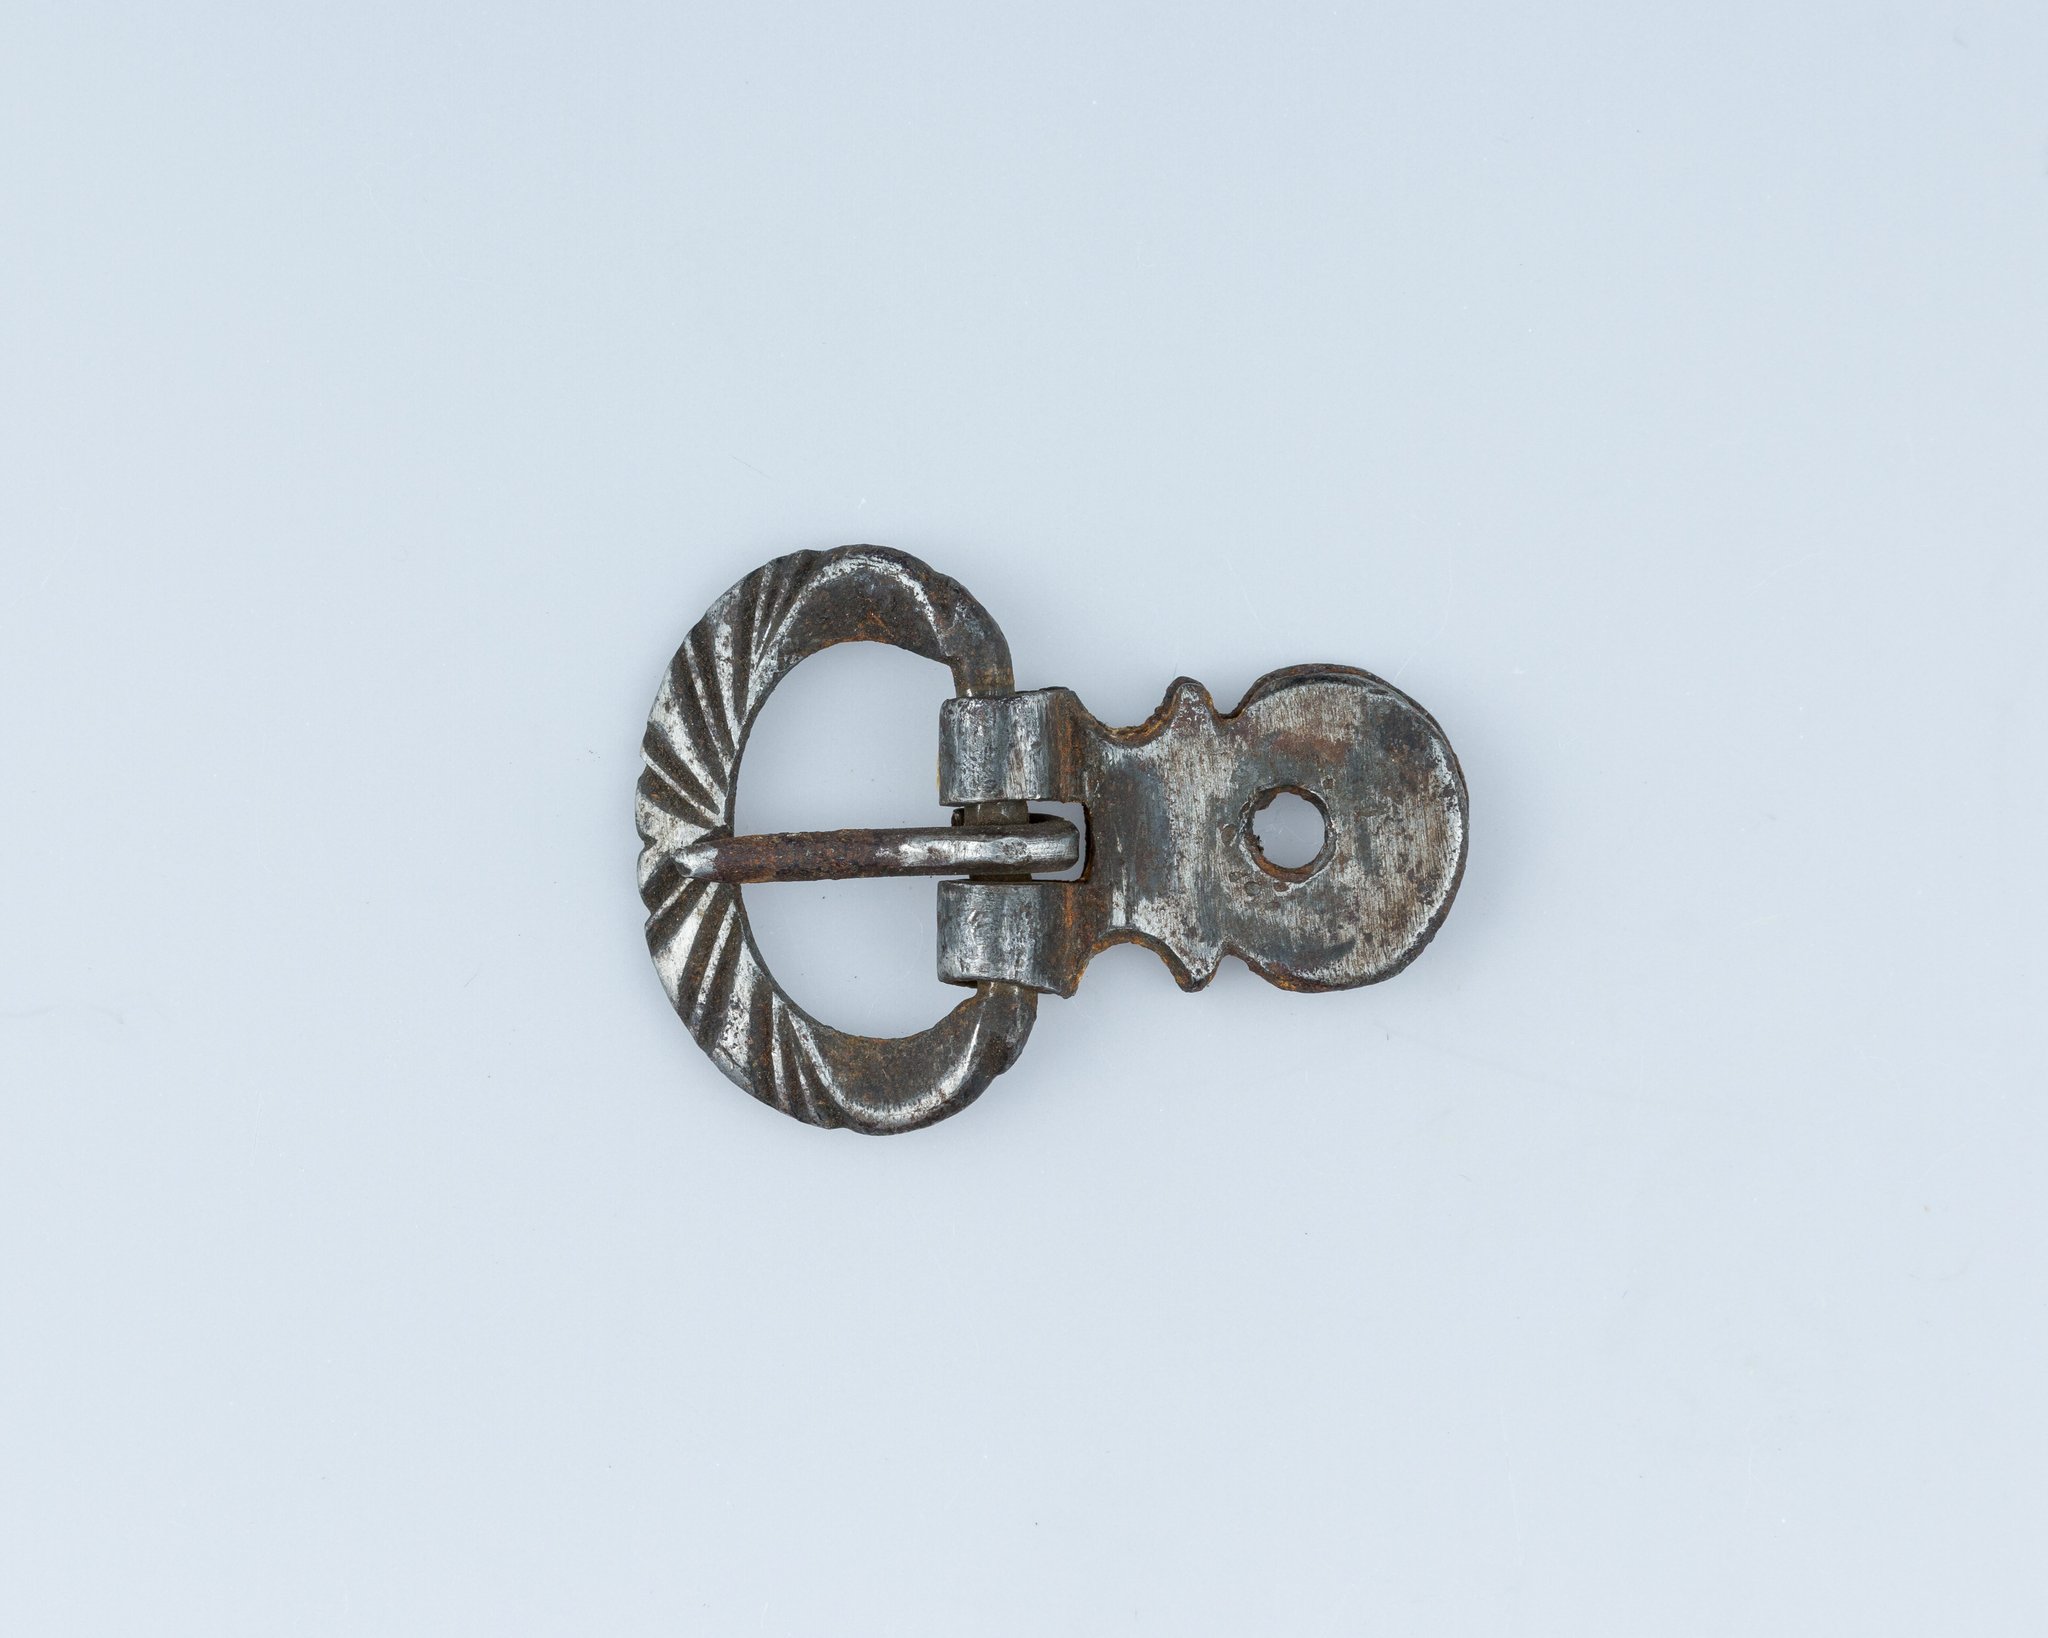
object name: buckle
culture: german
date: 1510-1520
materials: steel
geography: germany